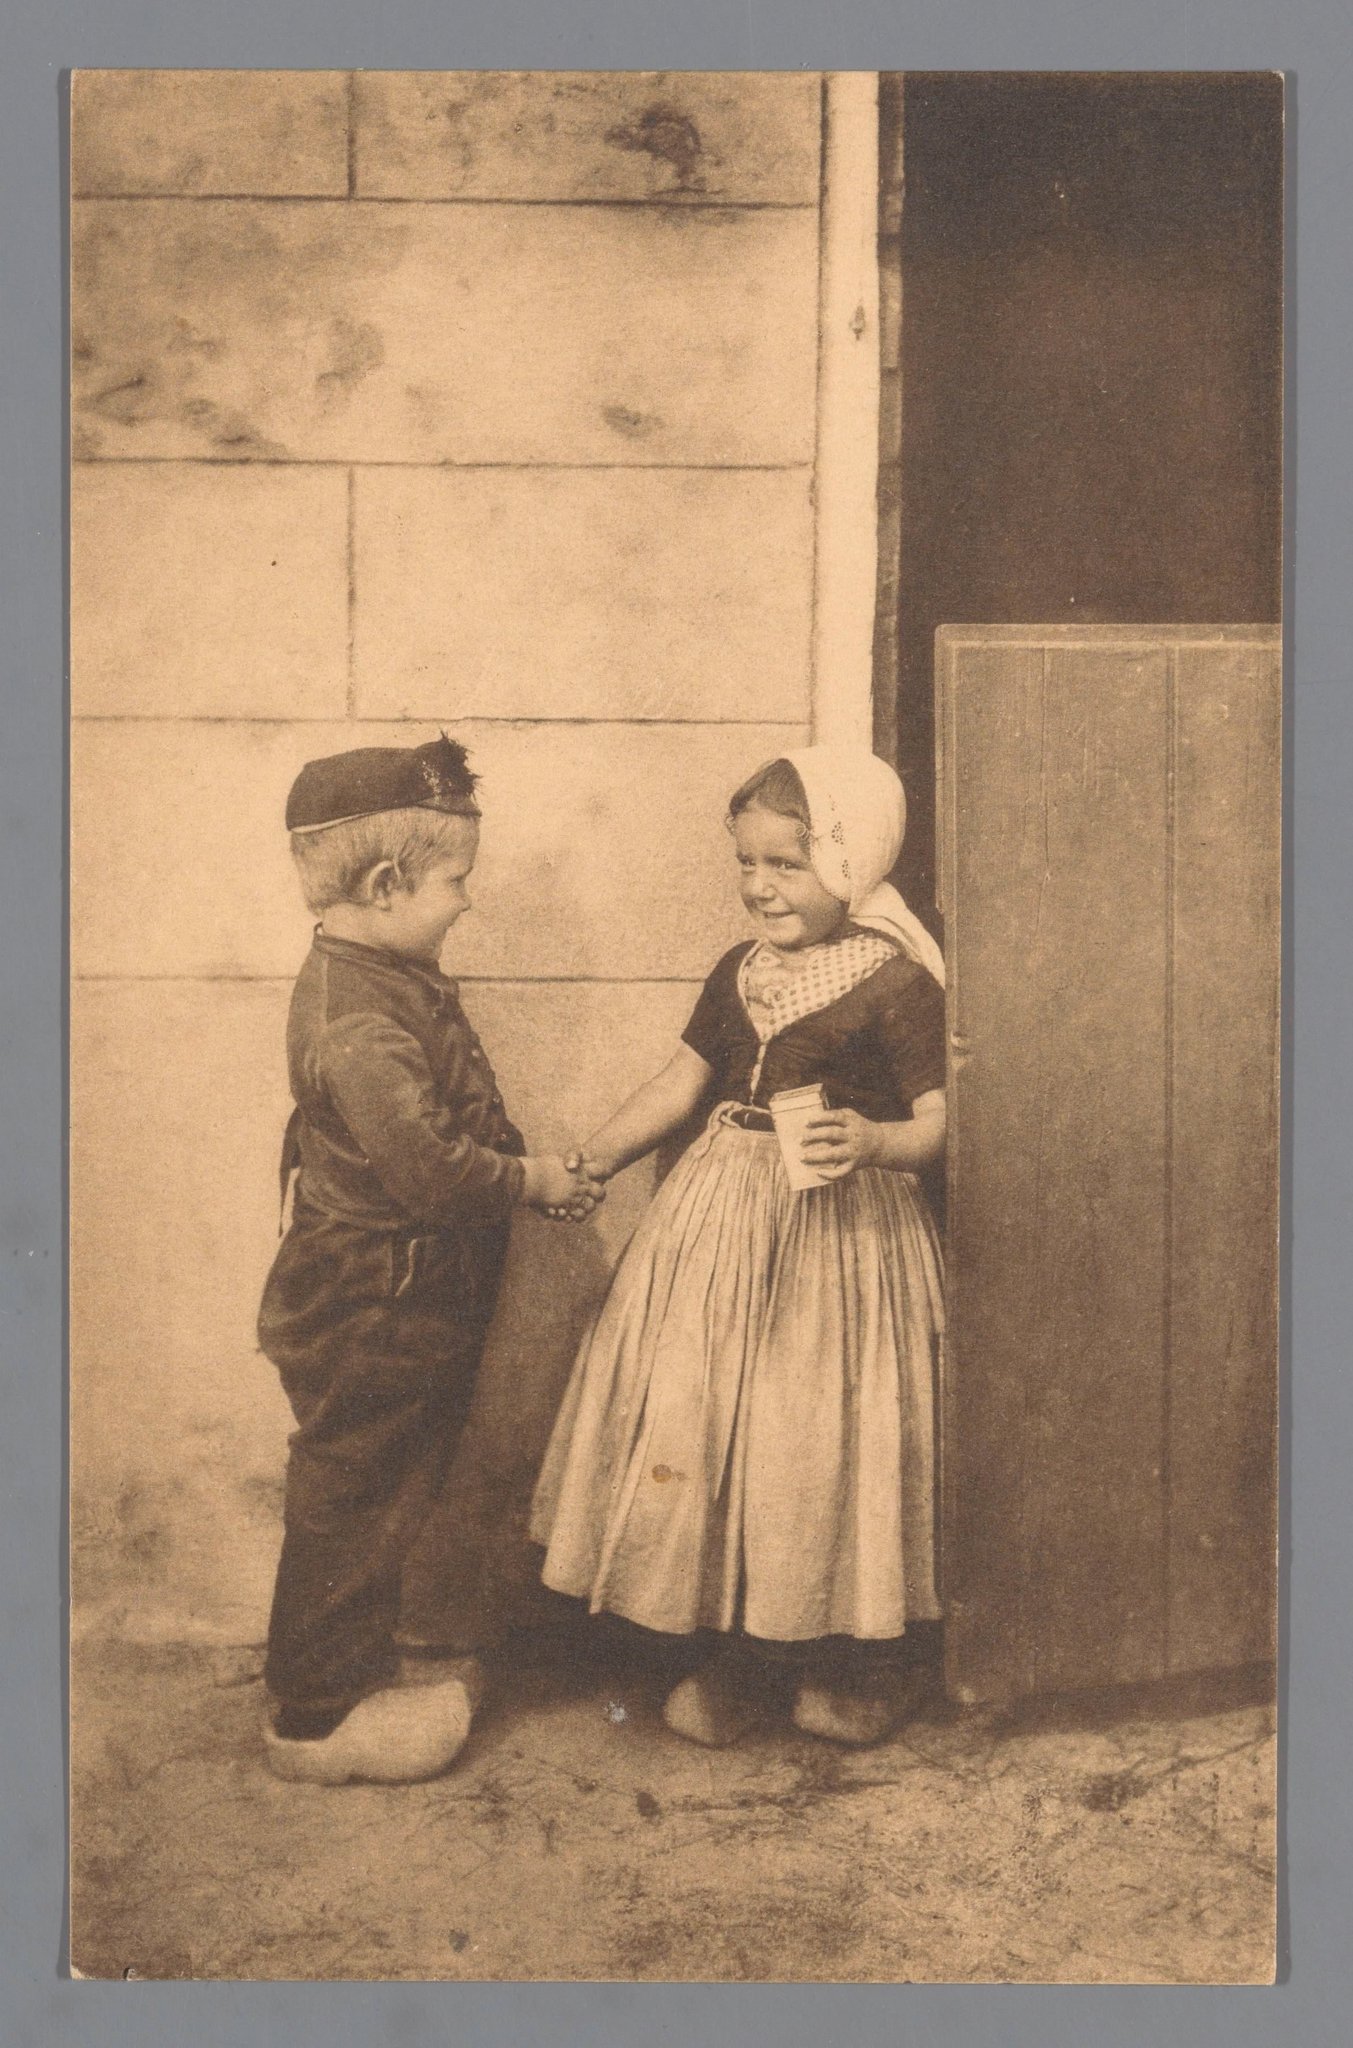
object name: ansichtkaart, prentbriefkaart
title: Hoe gaat het met je?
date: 1900-1920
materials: cardboard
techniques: photograph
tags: child, folk costume, regional costume